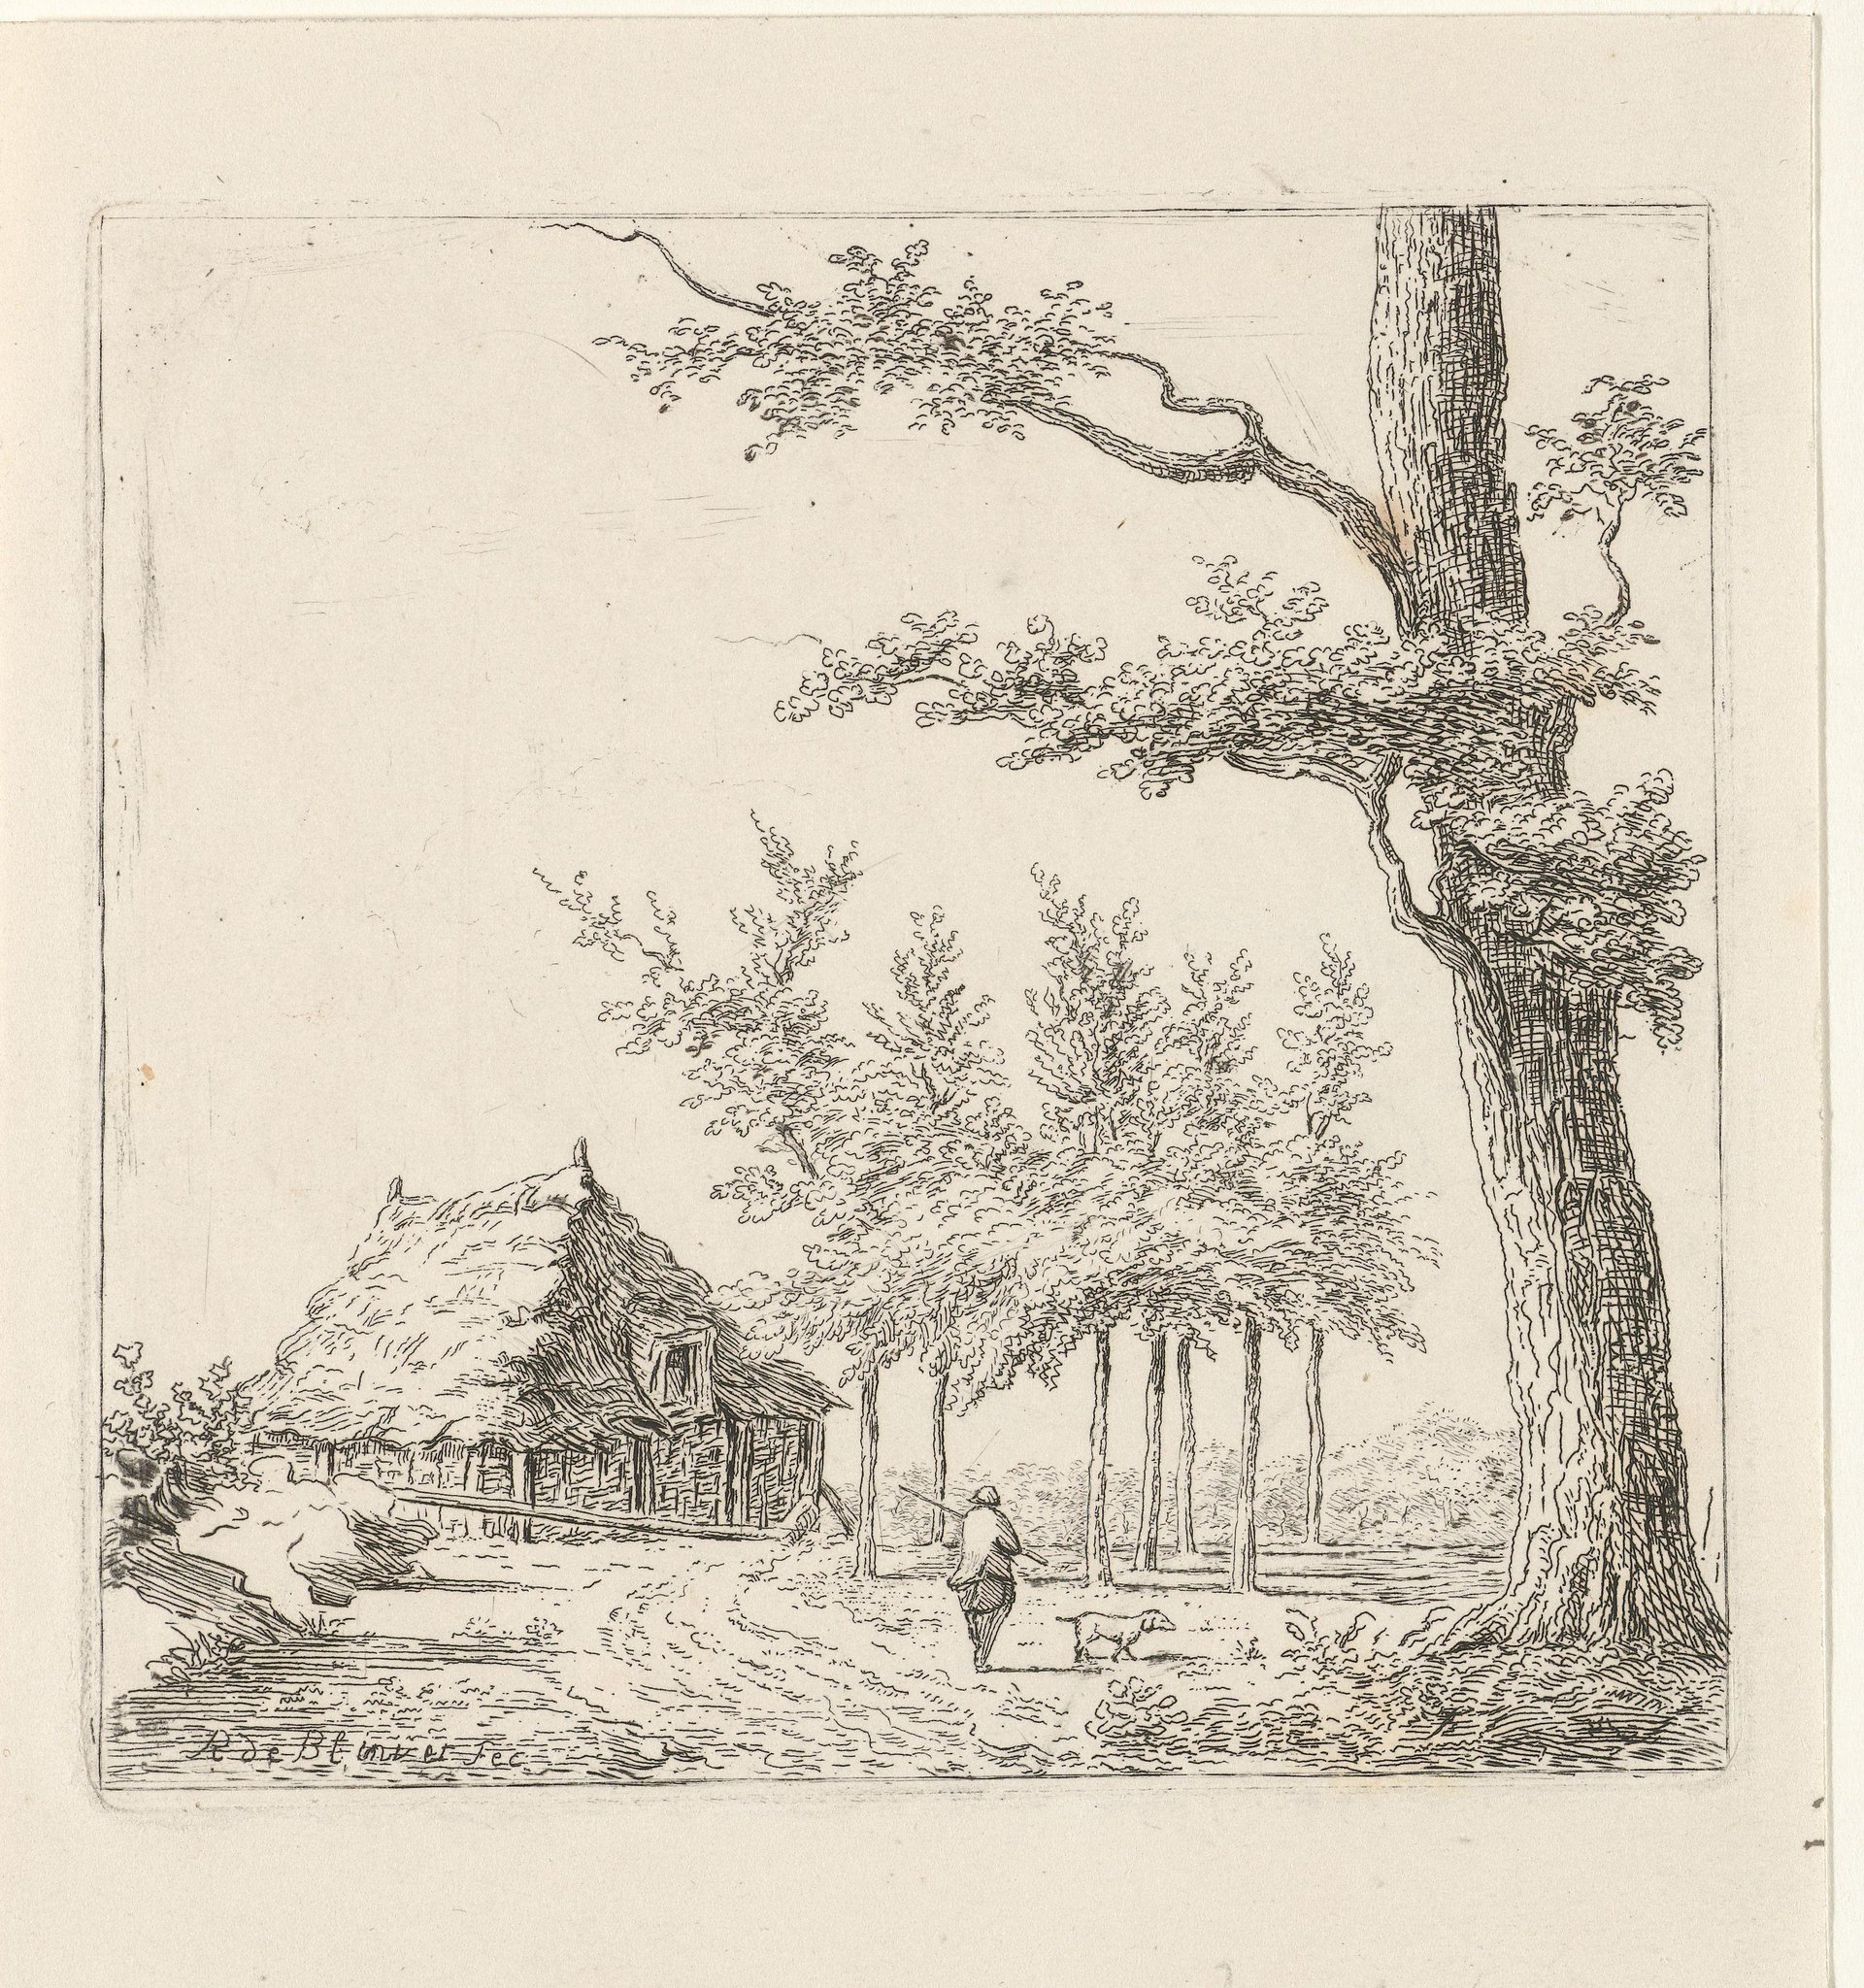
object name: print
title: Man met hond bij een boerderij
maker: reinierus albertus ludovicus baron van isendoorn à blois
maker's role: print maker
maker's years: 1786-1856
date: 1796-1856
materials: paper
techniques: etching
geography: vaassen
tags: farm or solitary house in landscape, dog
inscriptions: collector's mark: Lugt 2228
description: Een man loopt naast een hond, daarachter een groep bomen. Links een boerderij met een dak van stro. Rechts op de voorgrond een boom.